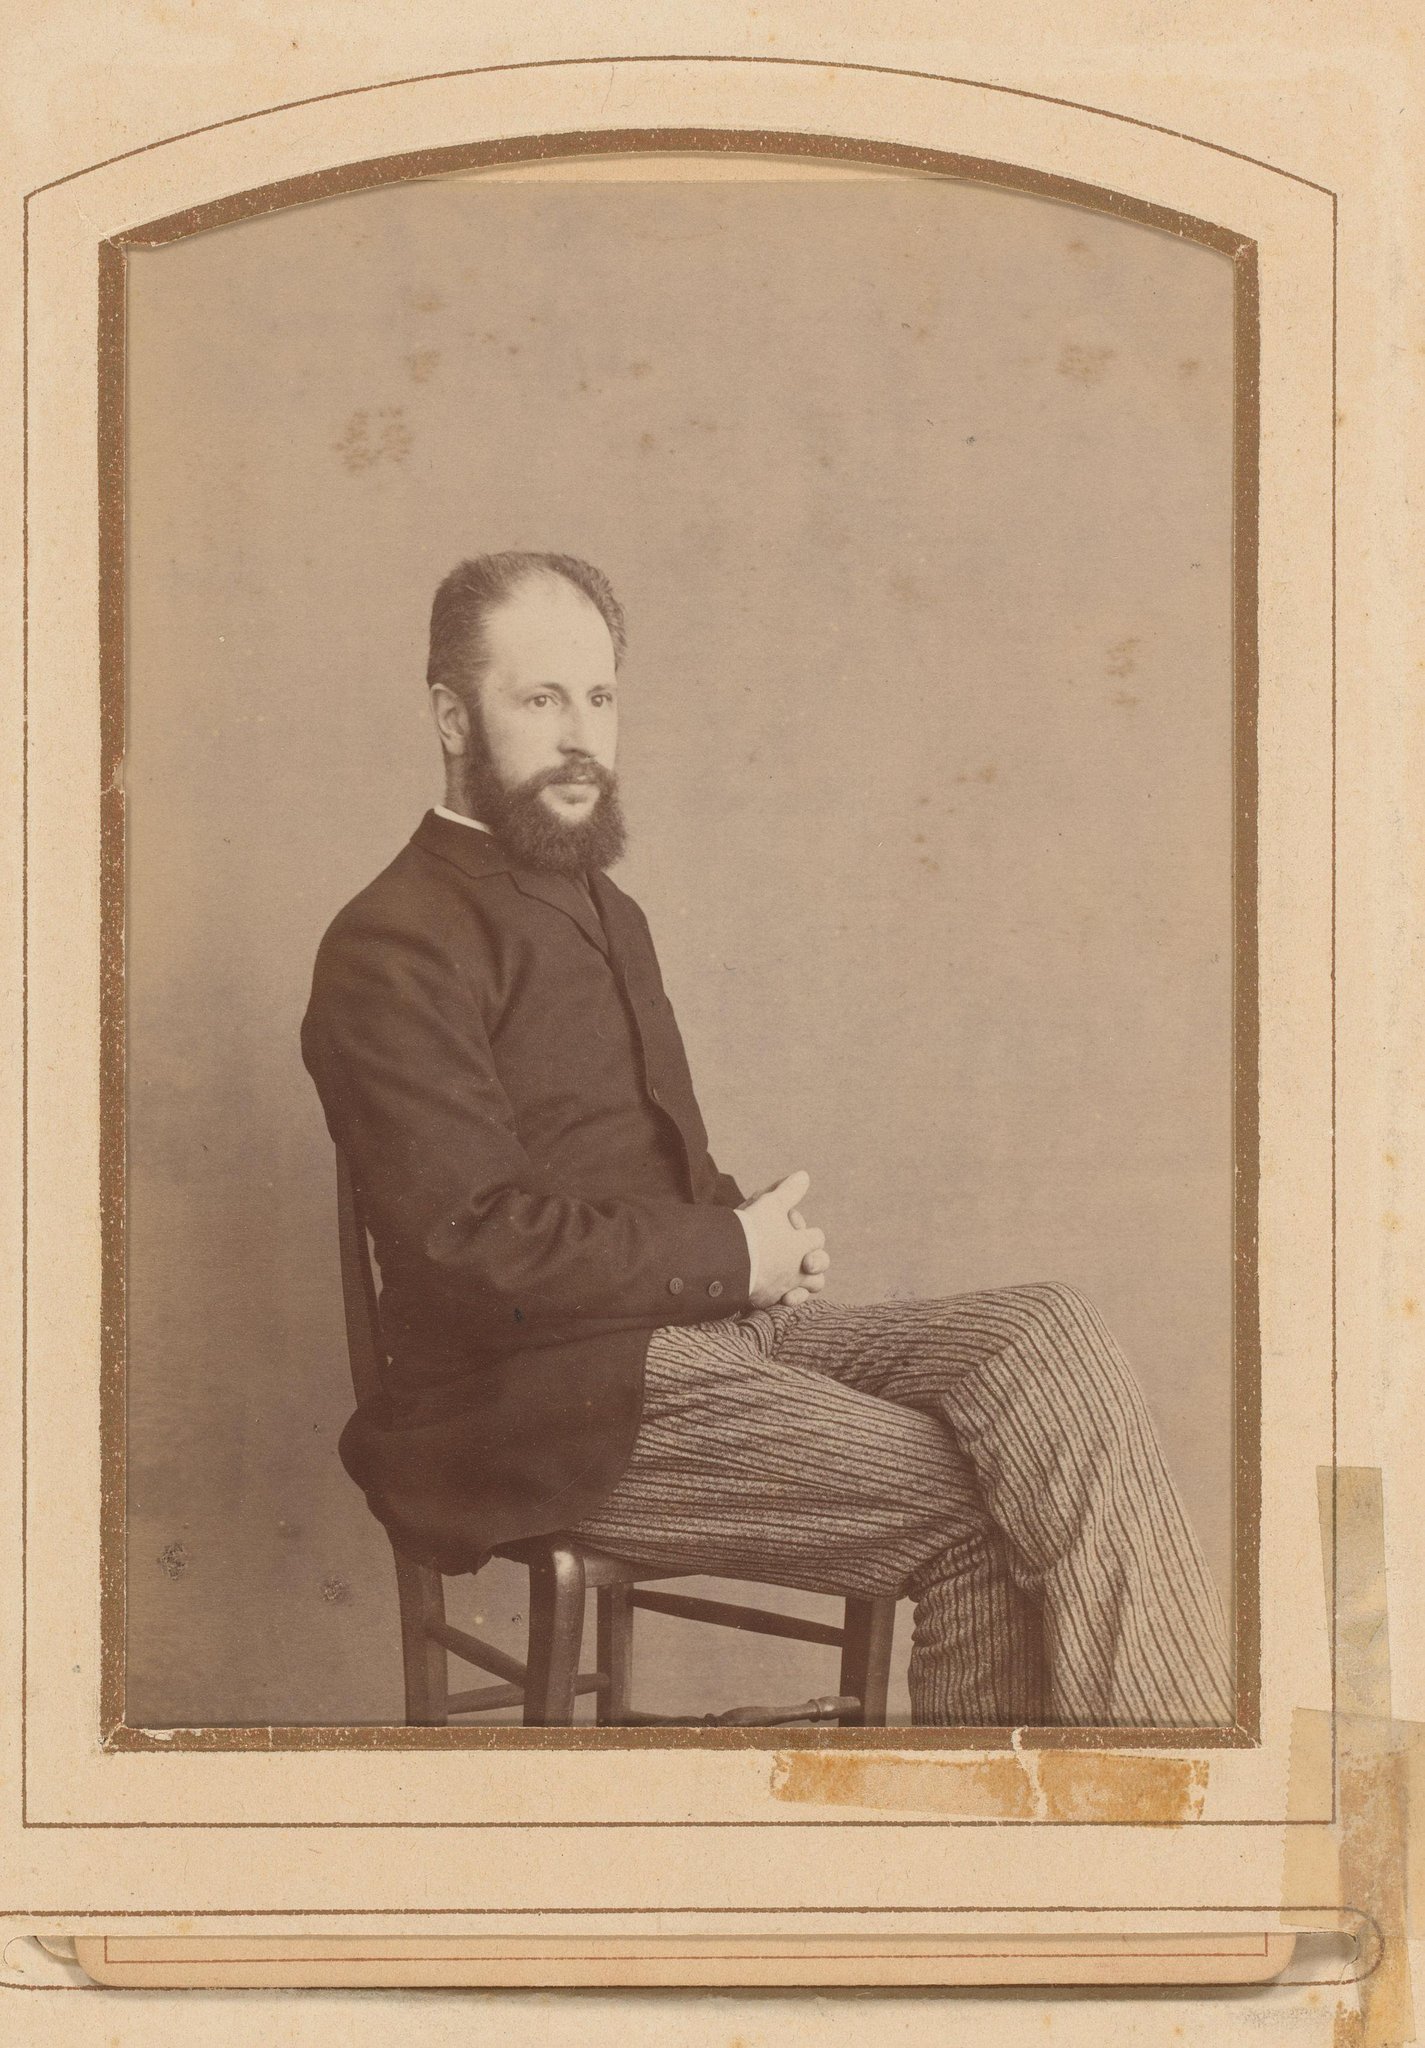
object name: photograph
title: Portret van een zittende man met snor en baard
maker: Anonymous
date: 1860-1900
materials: cardboard, photographic support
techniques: albumen print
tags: sitting figure, moustache, historical persons, beard